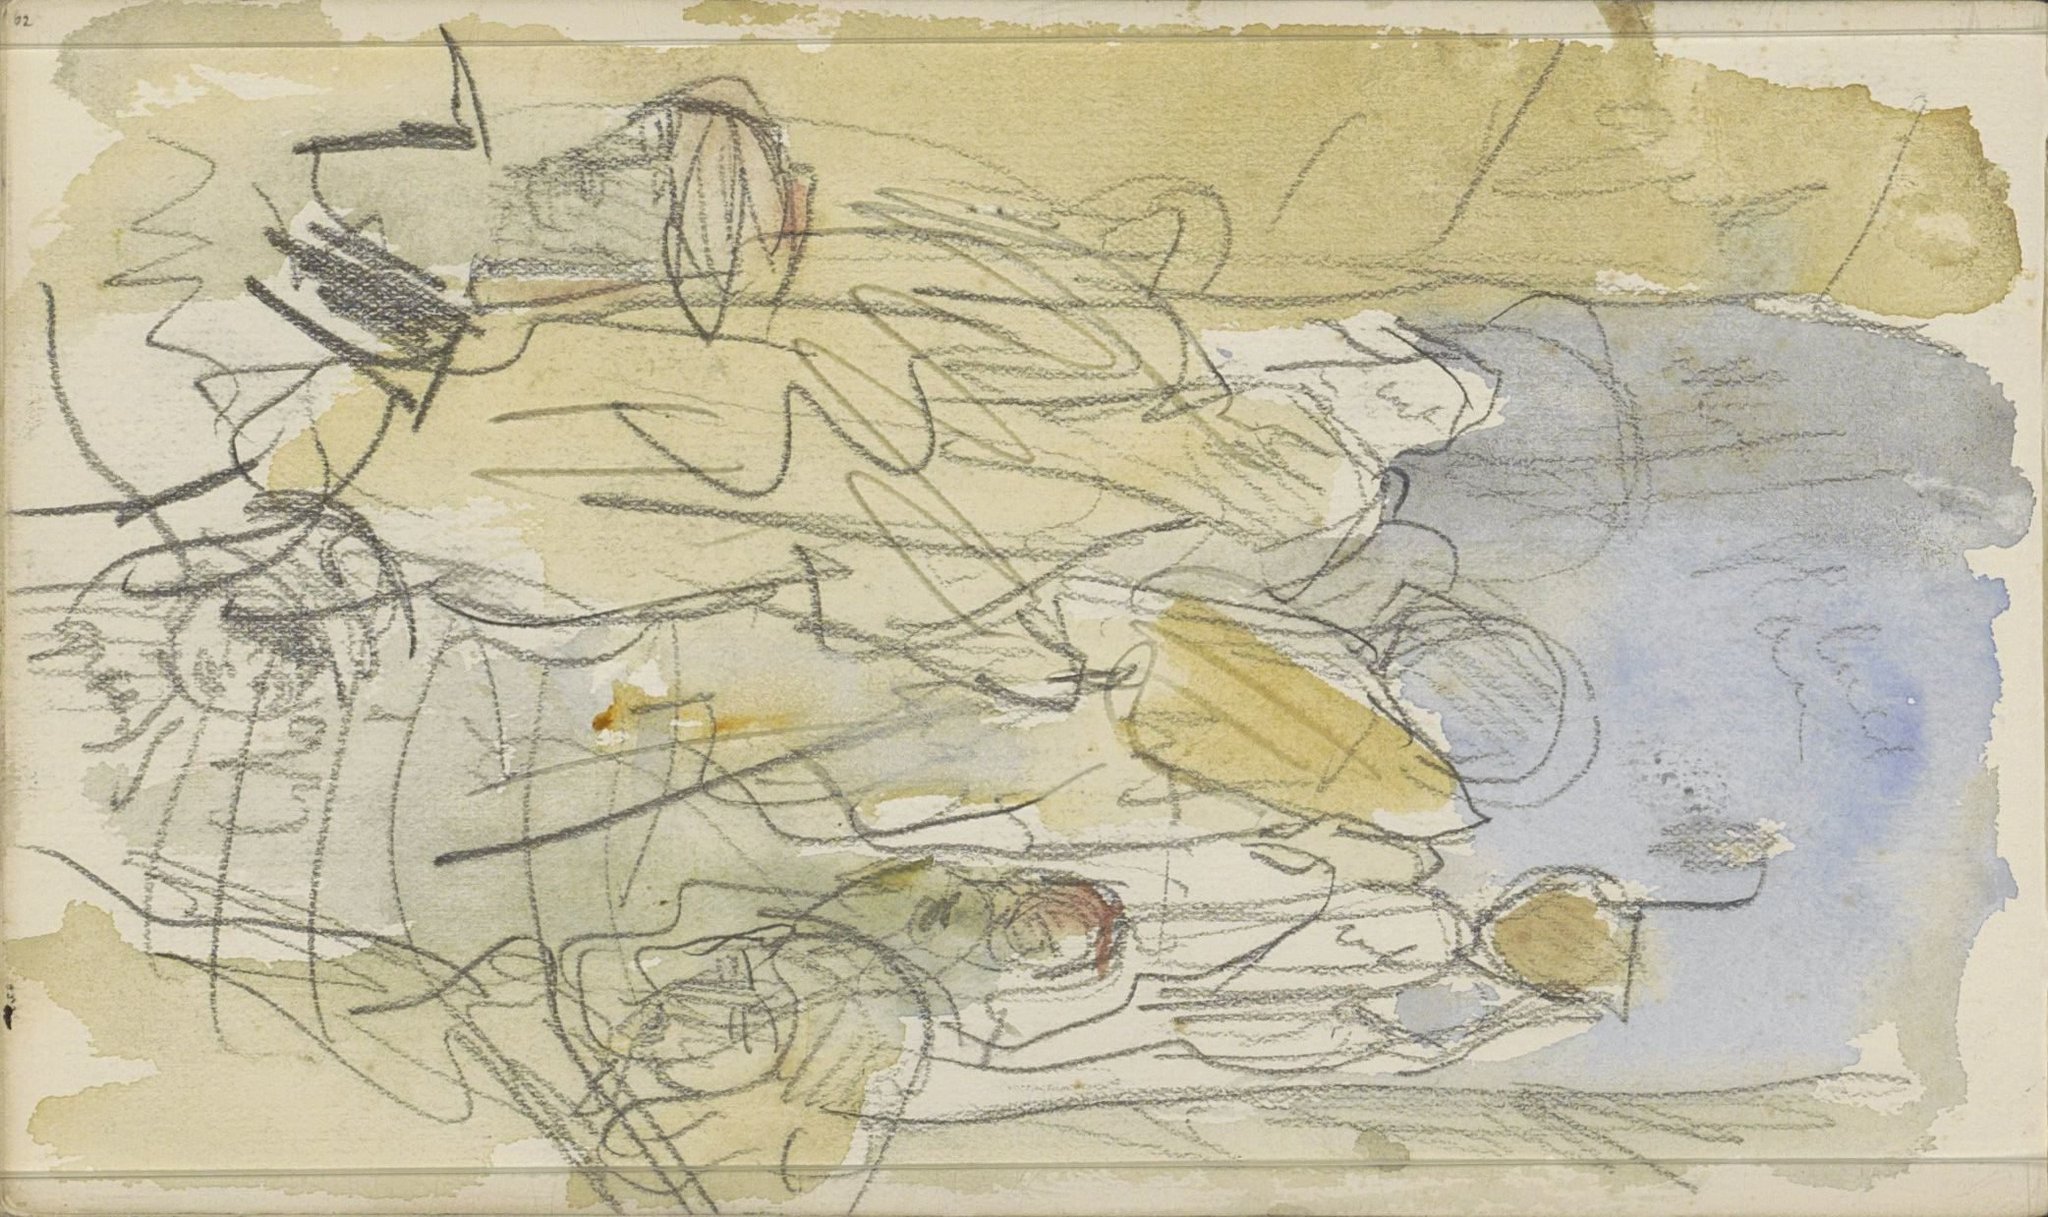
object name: sketchbook leaf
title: Straat met figuren op een trap in Biskra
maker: marius bauer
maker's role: draughtsman, print maker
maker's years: 1867-1932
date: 1922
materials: paper, pencil, watercolor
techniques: brush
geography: biskra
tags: flight of steps, africans, street (+ city(-scape) with figures, staffage)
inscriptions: kleurnotitie, handgeschreven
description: Pagina 62 uit een schetsboek met 31 bladen.